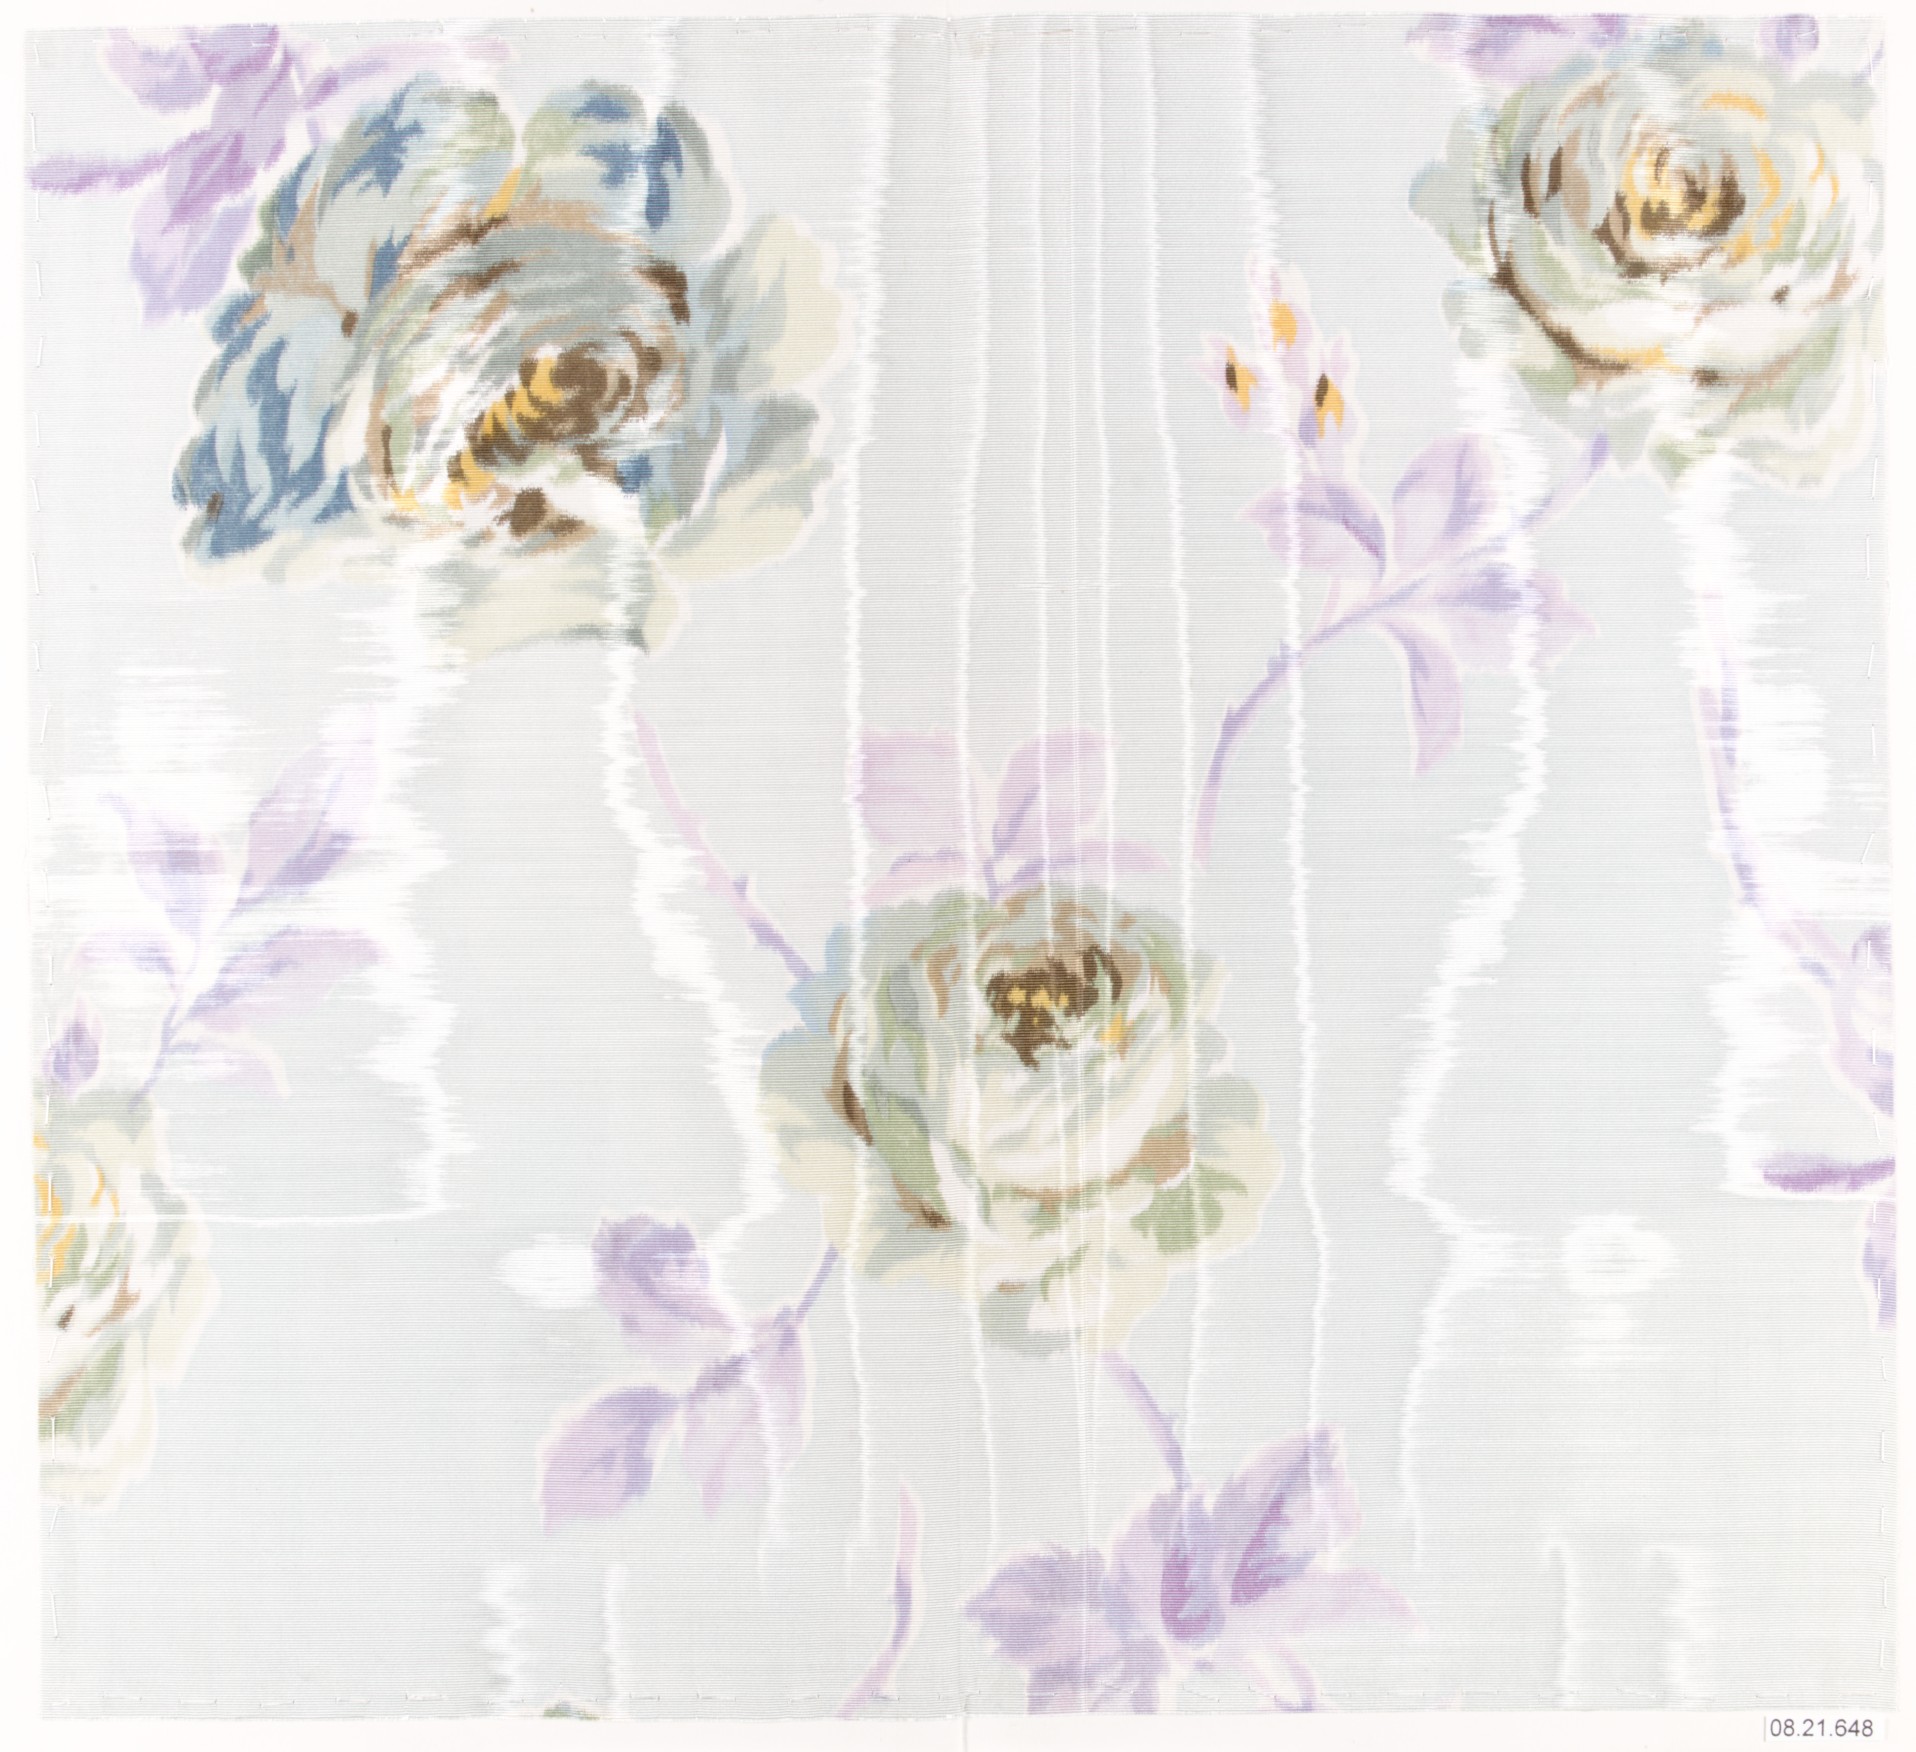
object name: textile sample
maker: Anonymous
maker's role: designer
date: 1900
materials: silk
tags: roses